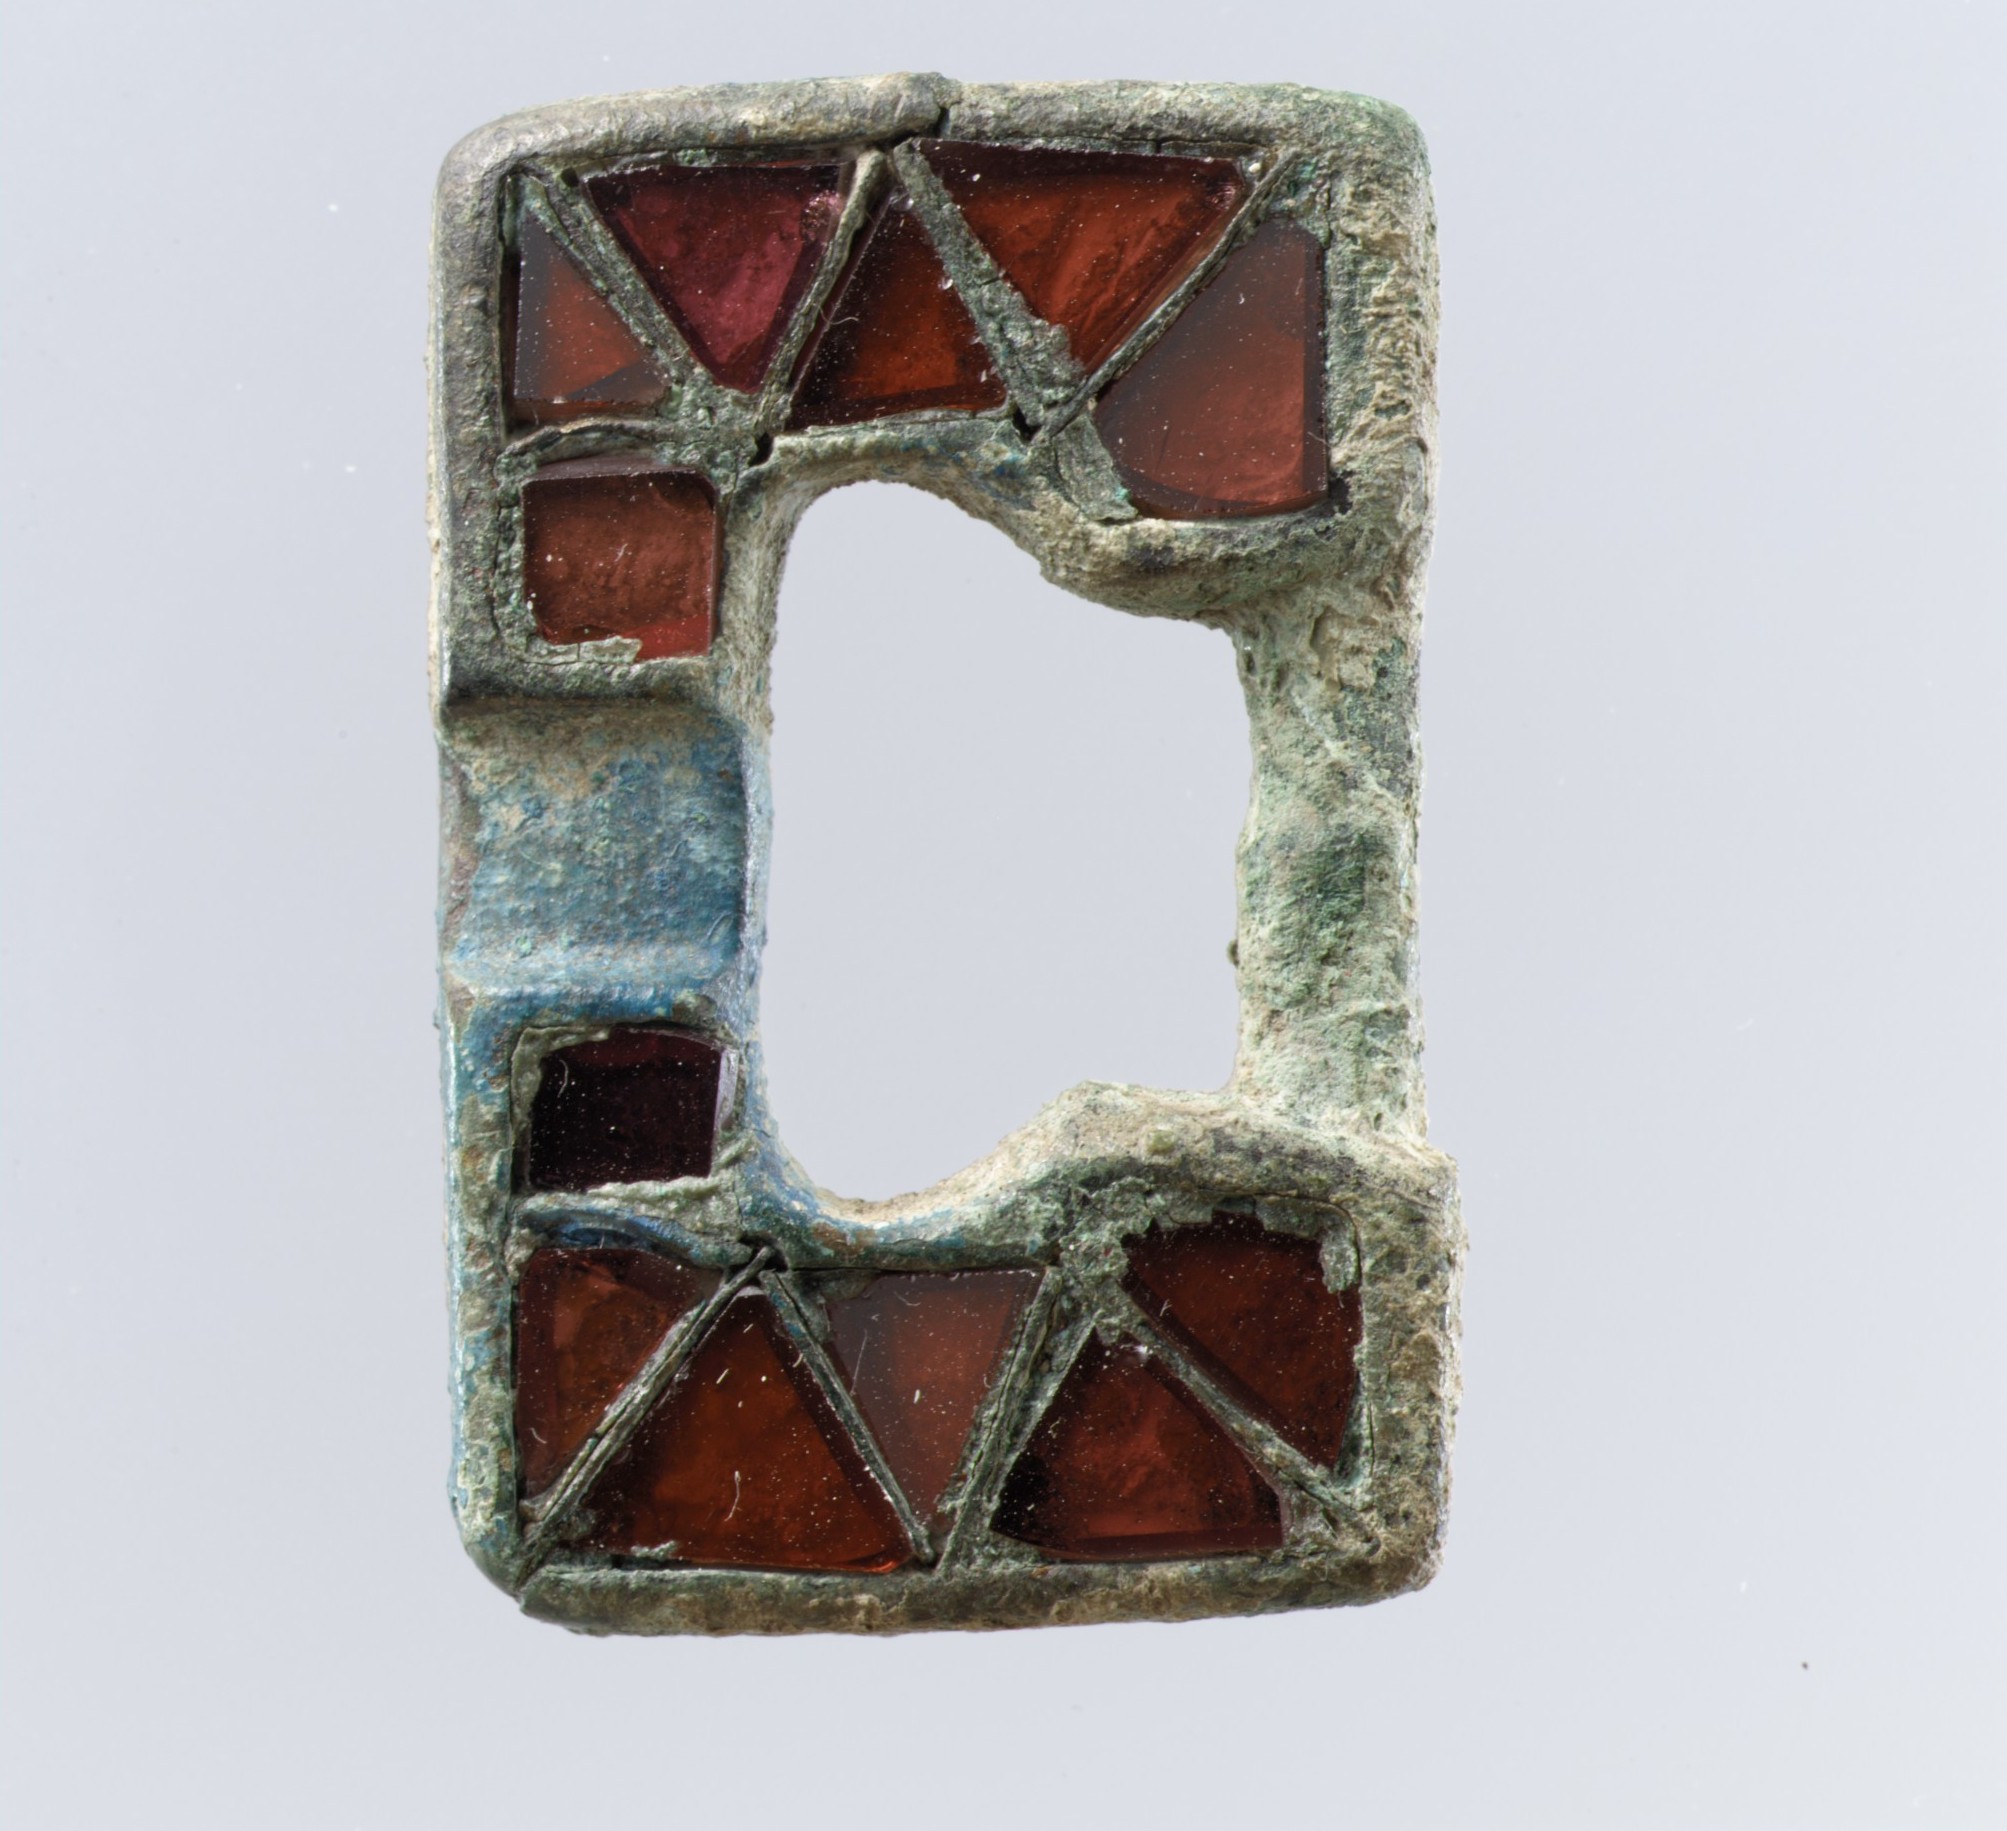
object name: buckle loop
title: Belt Buckle Loop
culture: frankish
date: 501-533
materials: copper alloy, garnet